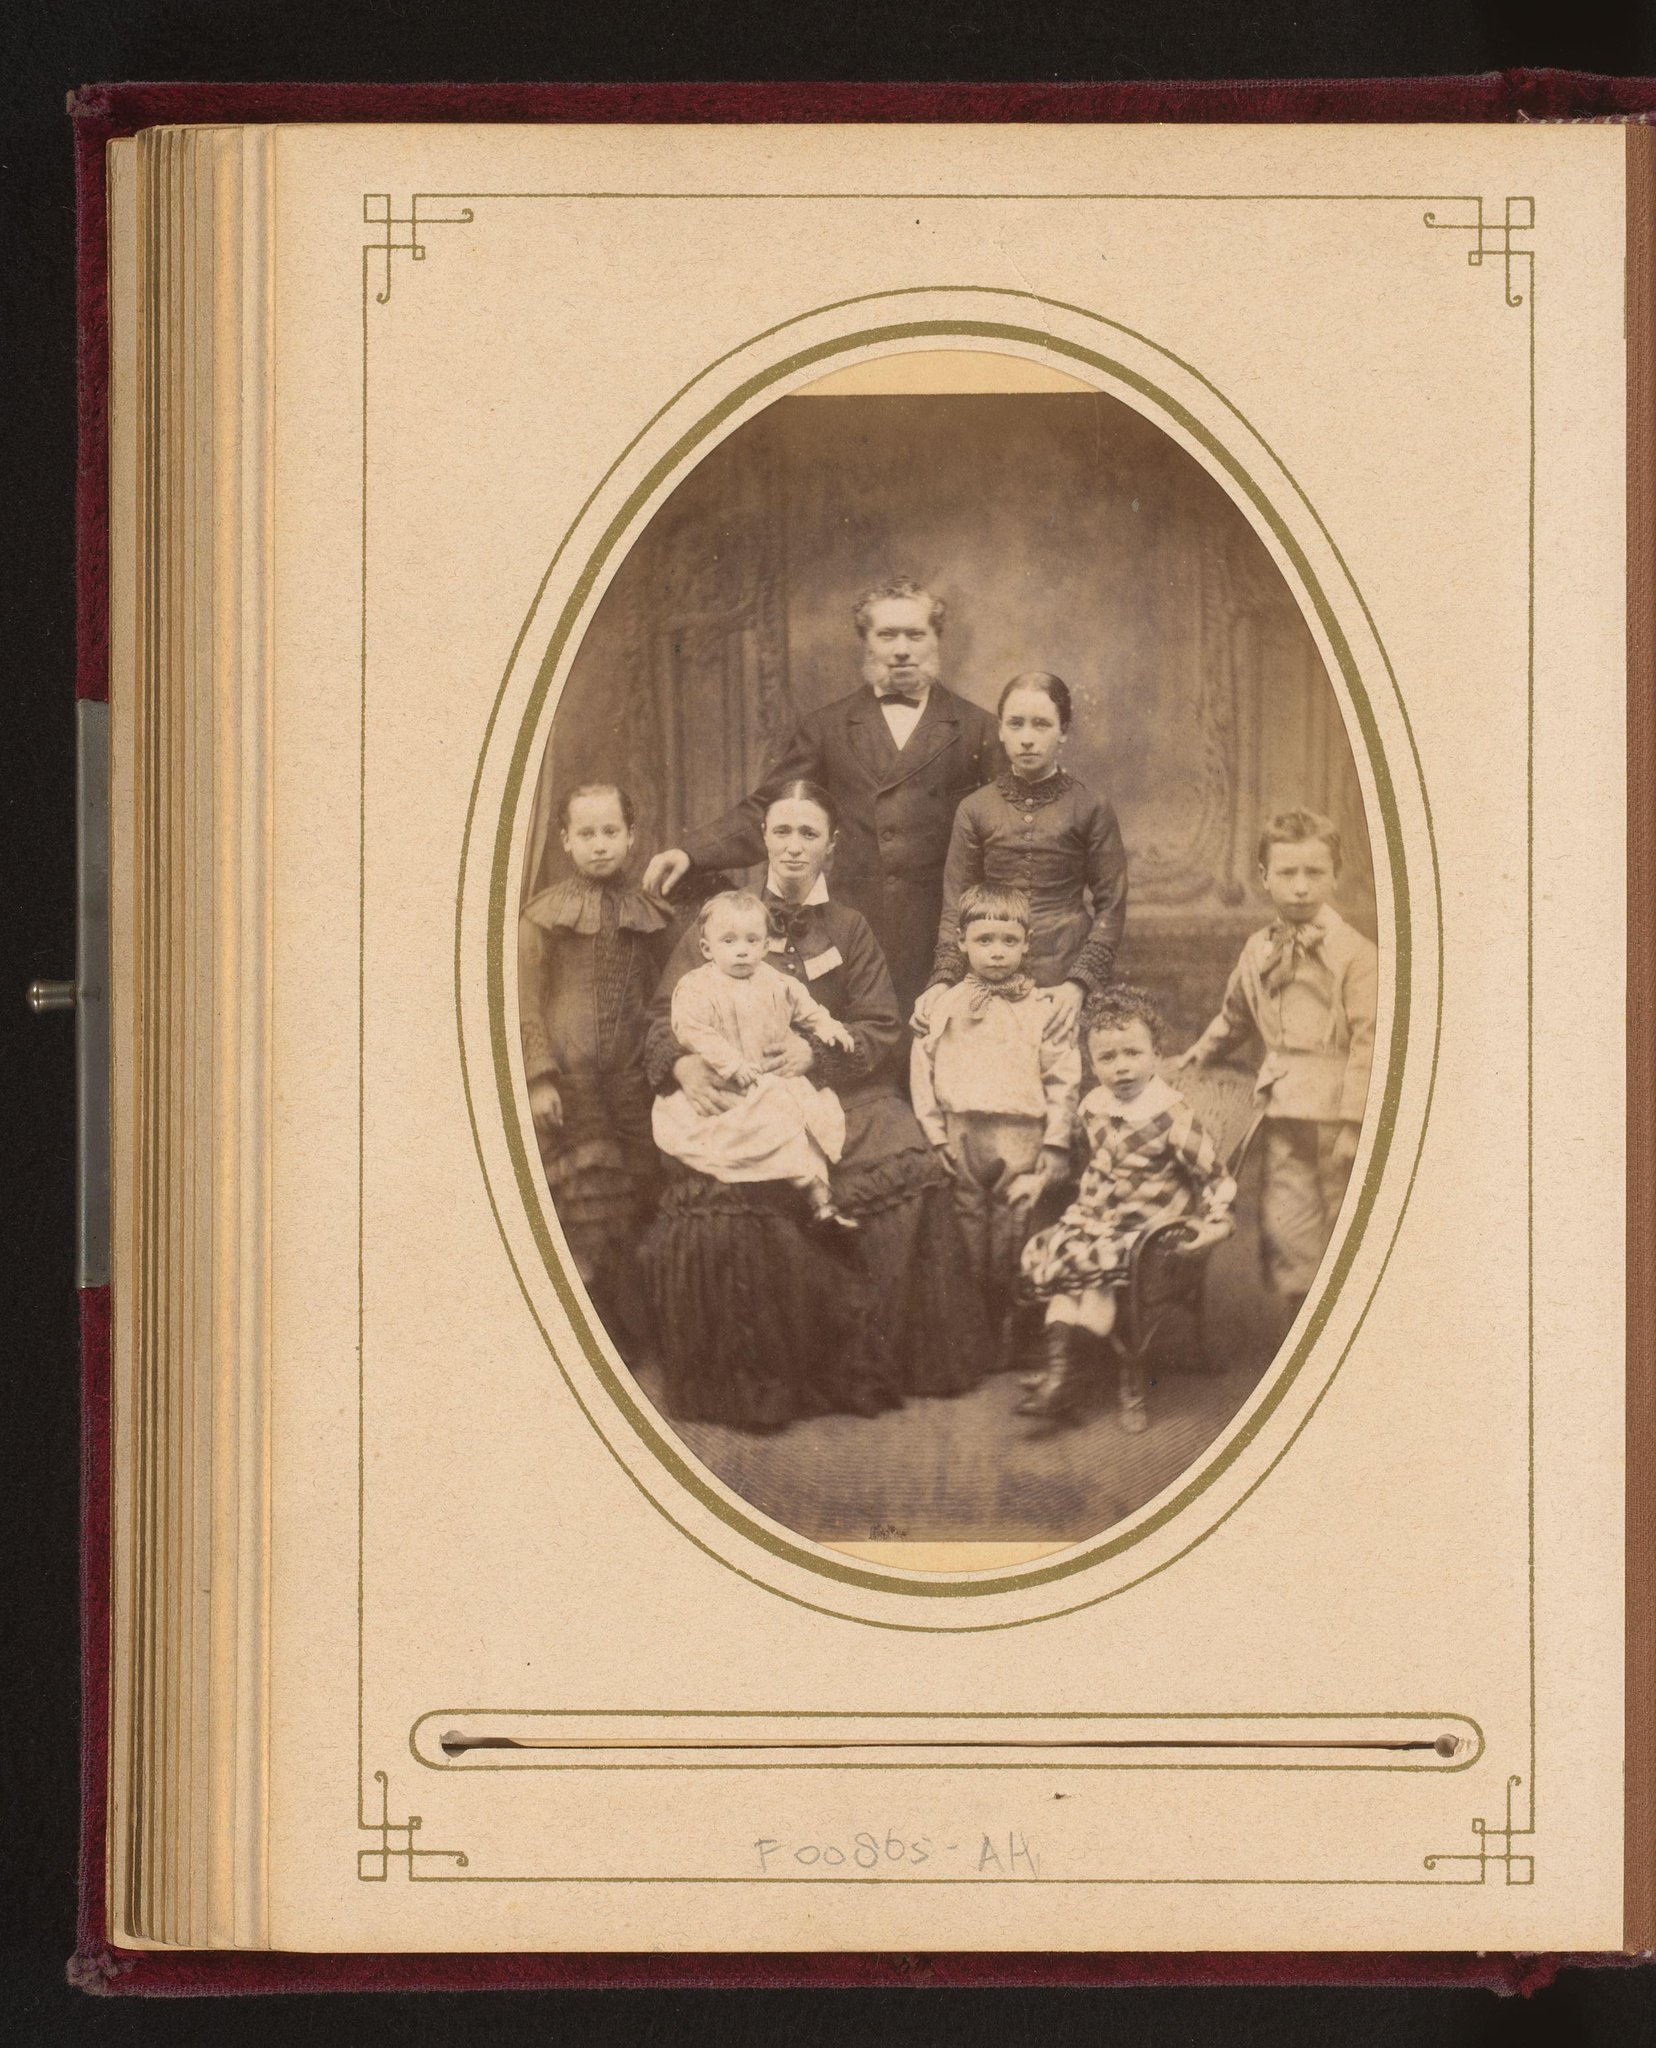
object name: cabinet photograph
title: Groepsportret van een gezin met zes kinderen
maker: Anonymous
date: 1870-1890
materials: cardboard, photographic support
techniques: albumen print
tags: parents with their children, child (+ six persons), anonymous historical persons portrayed in a group, in a group-portrait